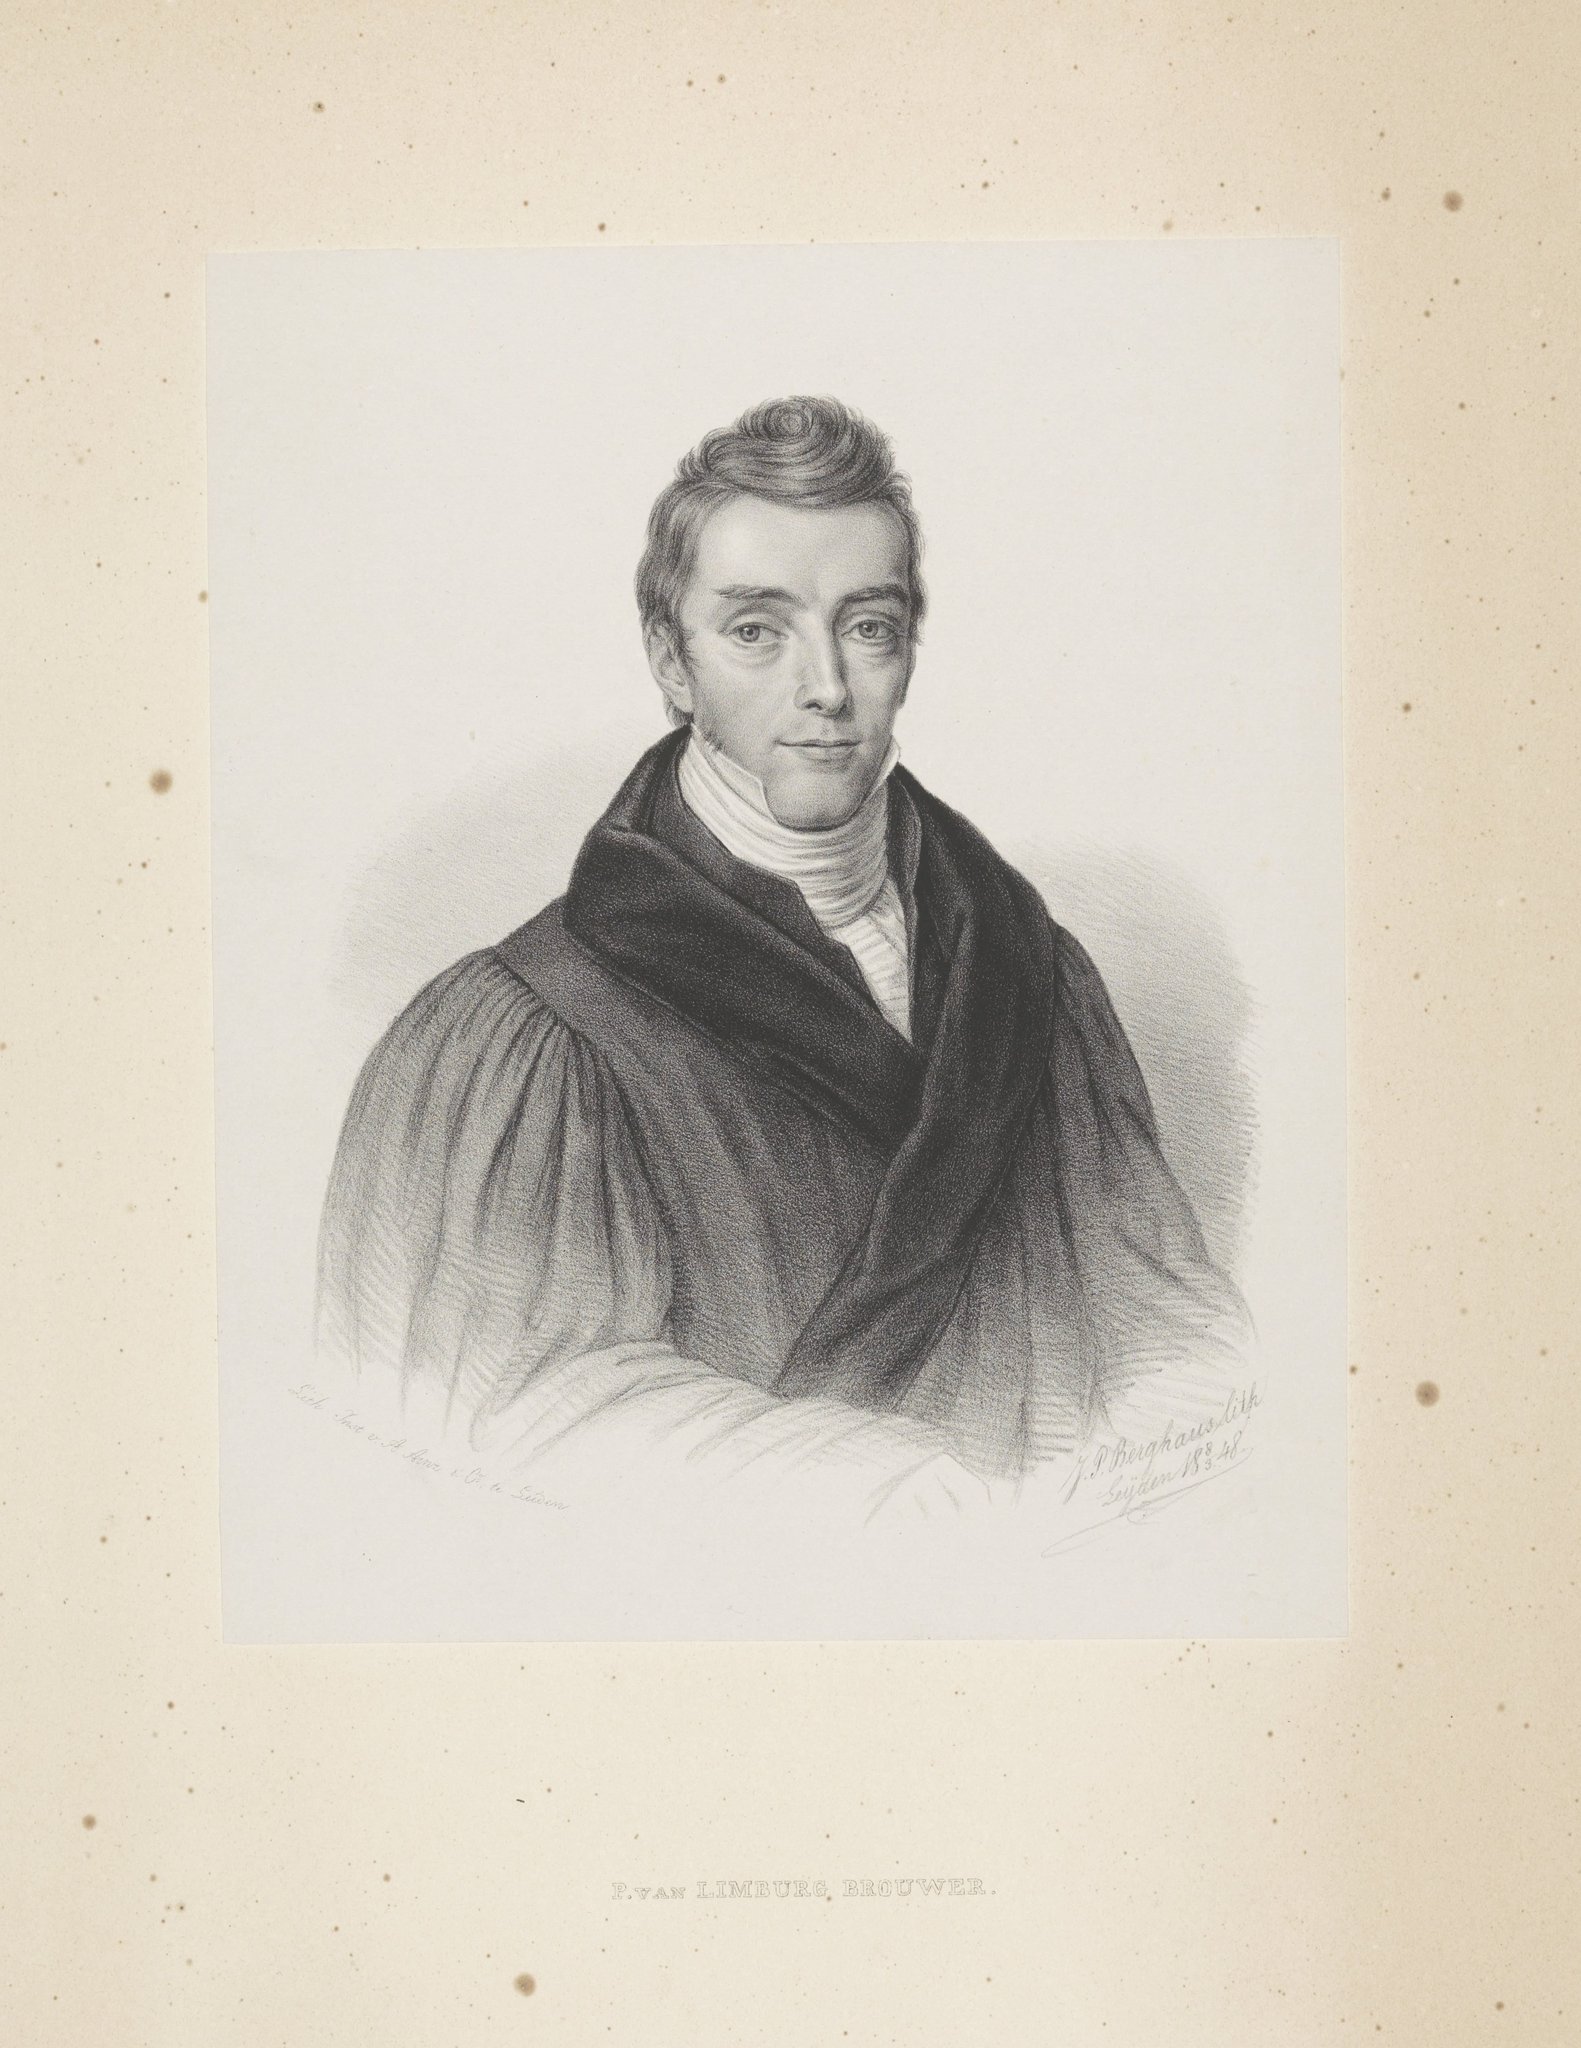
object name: print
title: Portret van Petrus van Limburg Brouwer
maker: johann peter berghaus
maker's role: print maker, printer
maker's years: 1810-1870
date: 1848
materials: paper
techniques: lithograph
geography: leiden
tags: dordrecht, historical persons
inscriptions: collector's mark: Lugt 2228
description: De geportretteerde draagt een met bond afgezette jas en een brede hoge kraag.